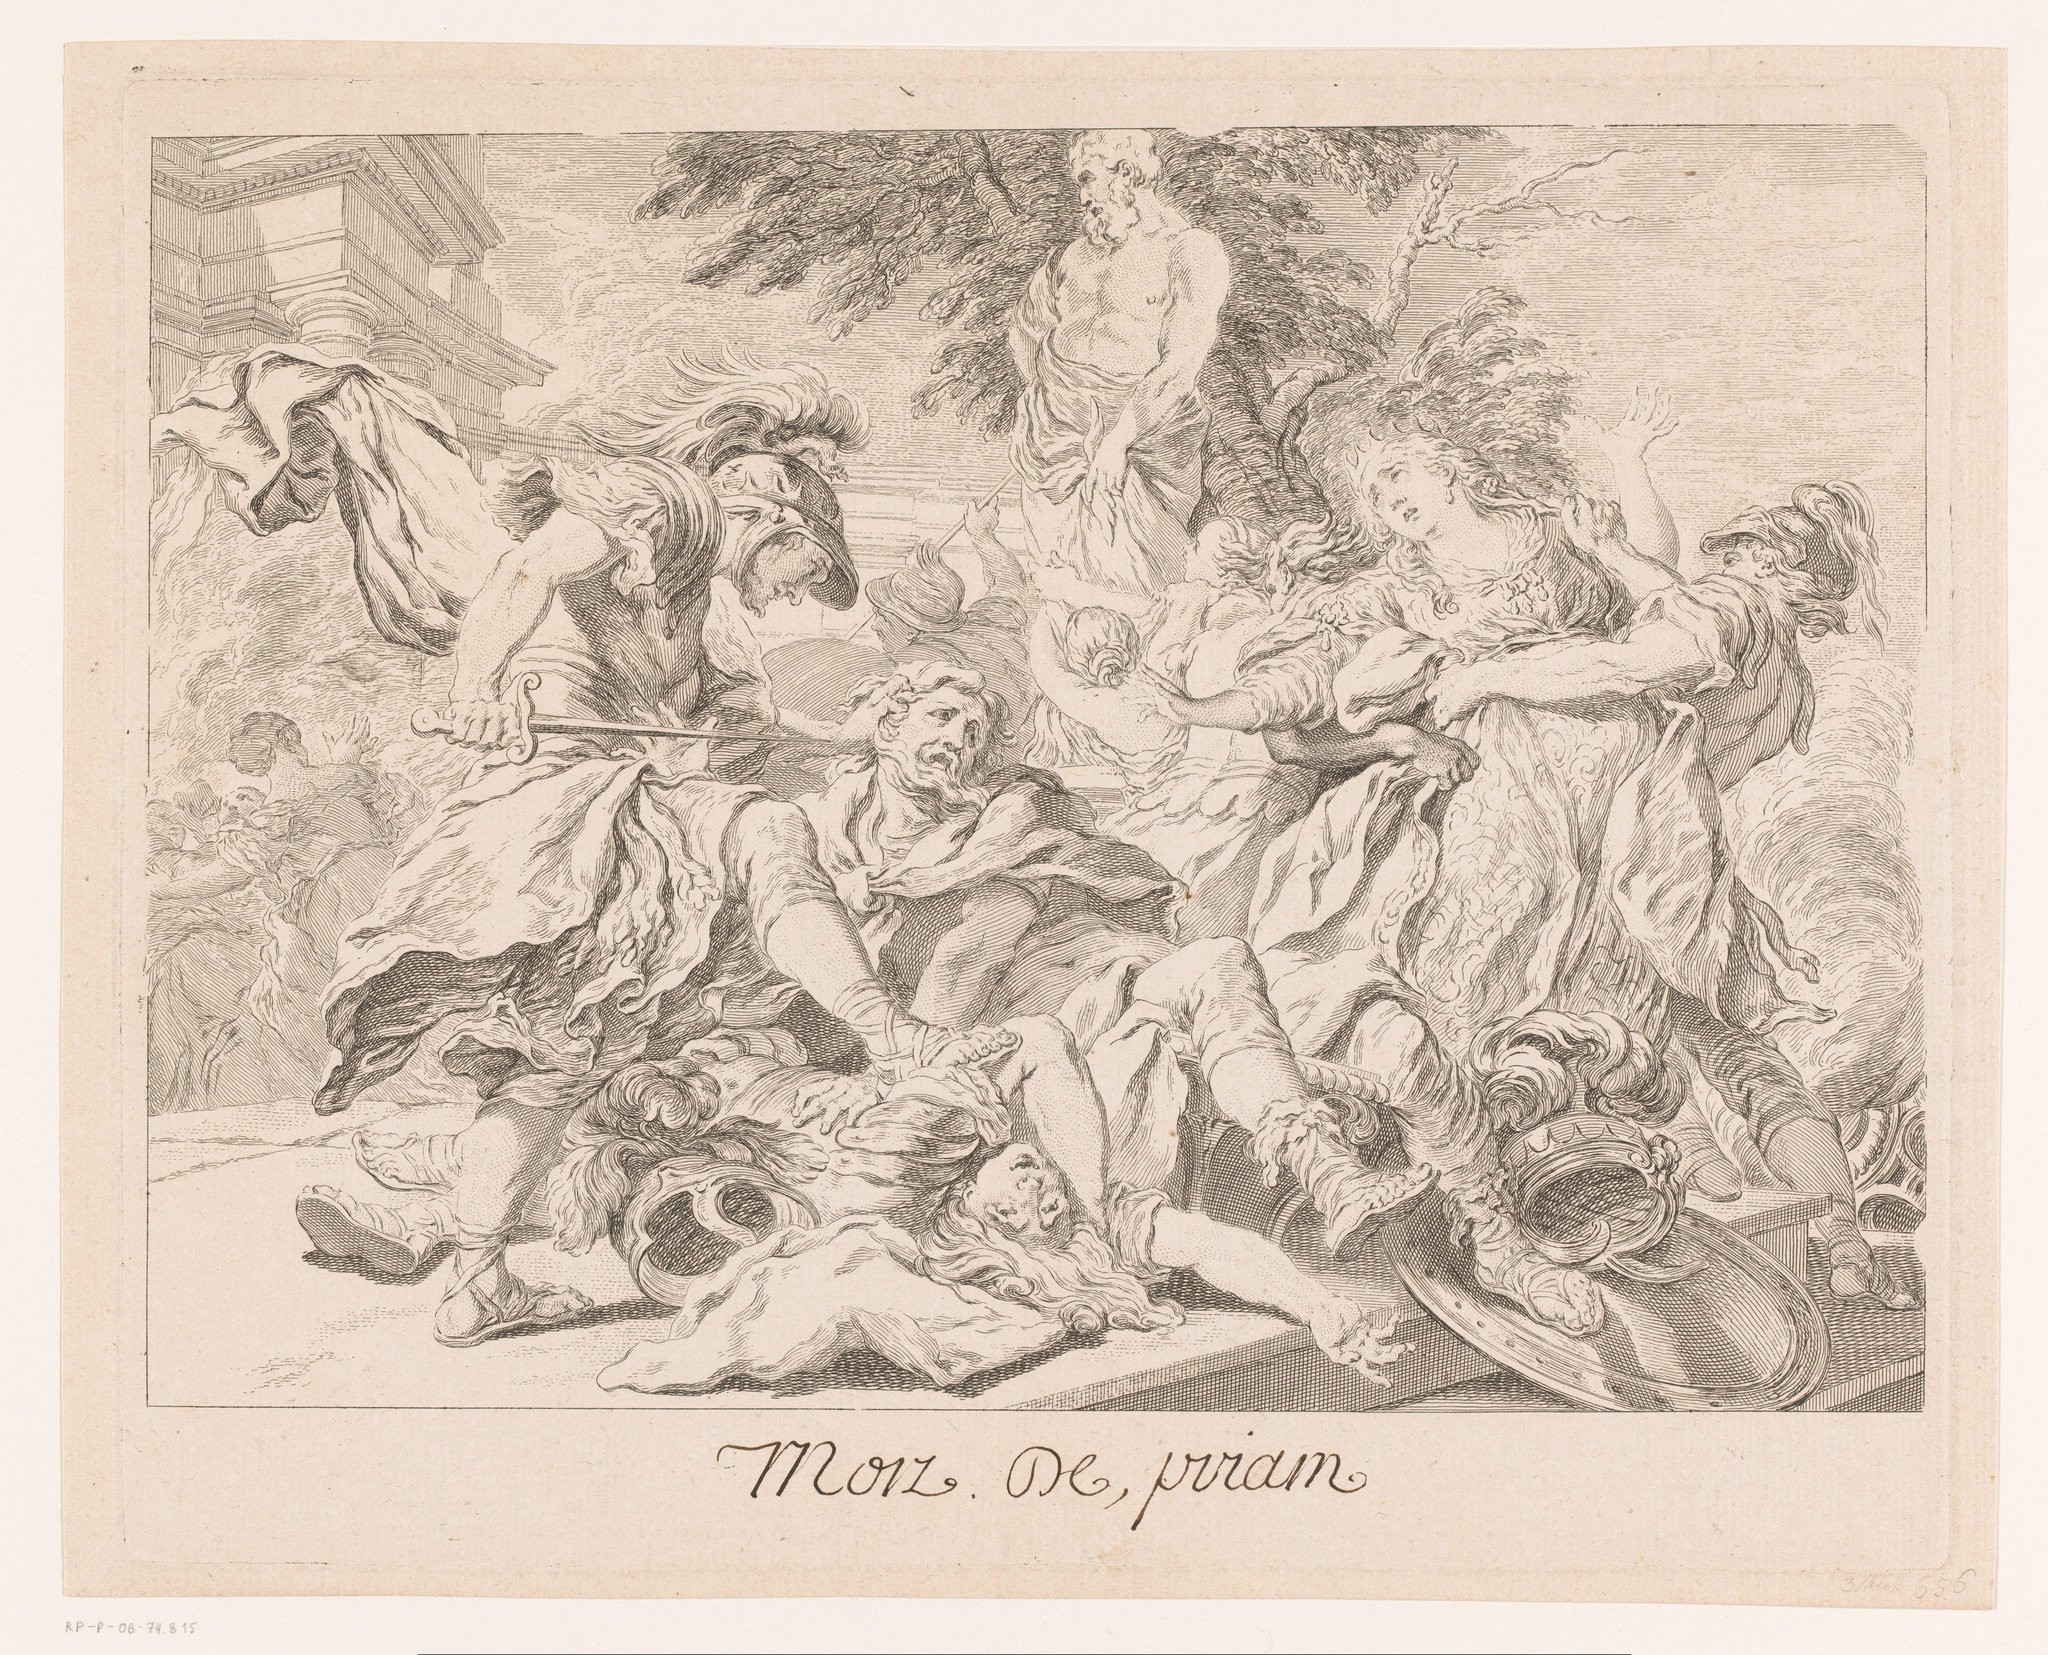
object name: print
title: Dood van Priamus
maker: Anonymous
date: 1600-1700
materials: paper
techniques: engraving, etching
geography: france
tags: (story of) priam - death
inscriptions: title: ‘Mort. De, priam’, collector's mark: Lugt 240